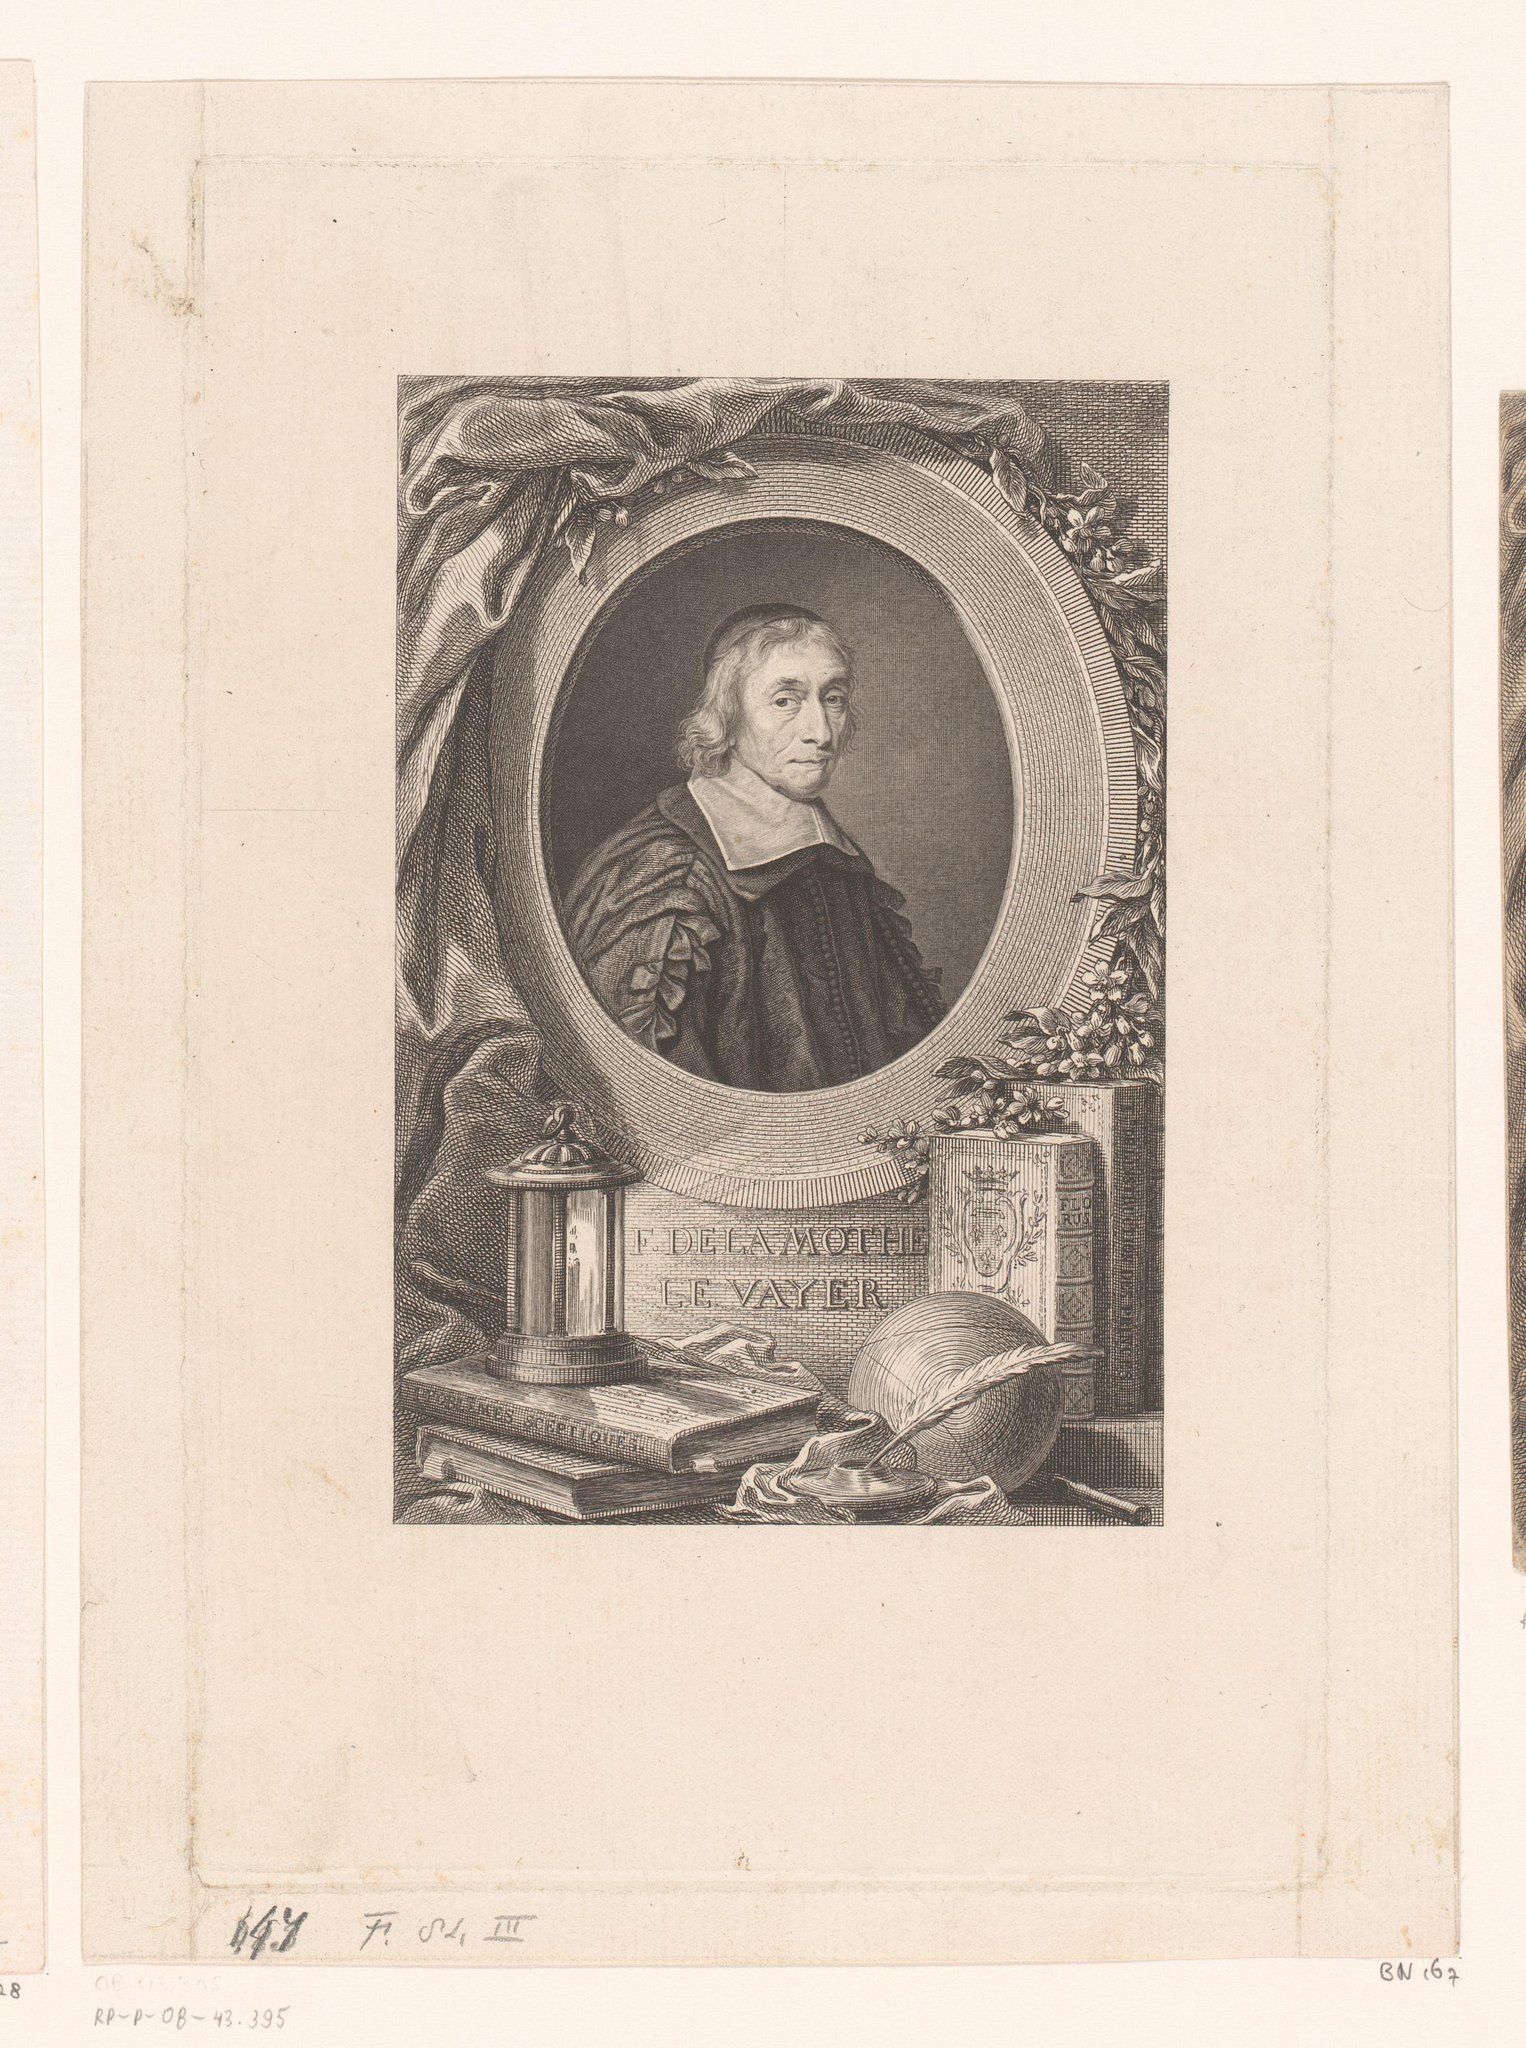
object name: print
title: Portret van François de La Mothe Le Vayer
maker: etienne ficquet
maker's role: print maker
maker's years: 1719-1794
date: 1775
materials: paper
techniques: engraving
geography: france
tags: paris, ornament ~ medallion, historical persons, portrait of a writer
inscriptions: collector's mark: Lugt 240